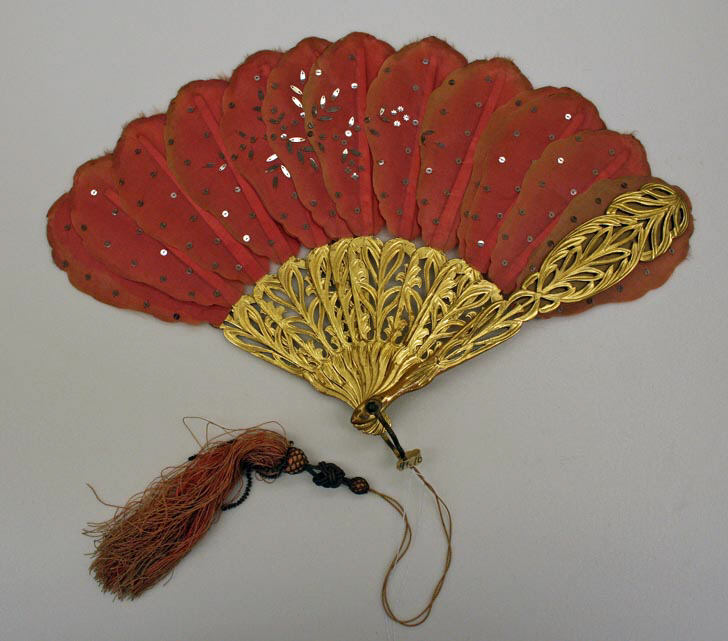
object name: fan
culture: french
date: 1868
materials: silk